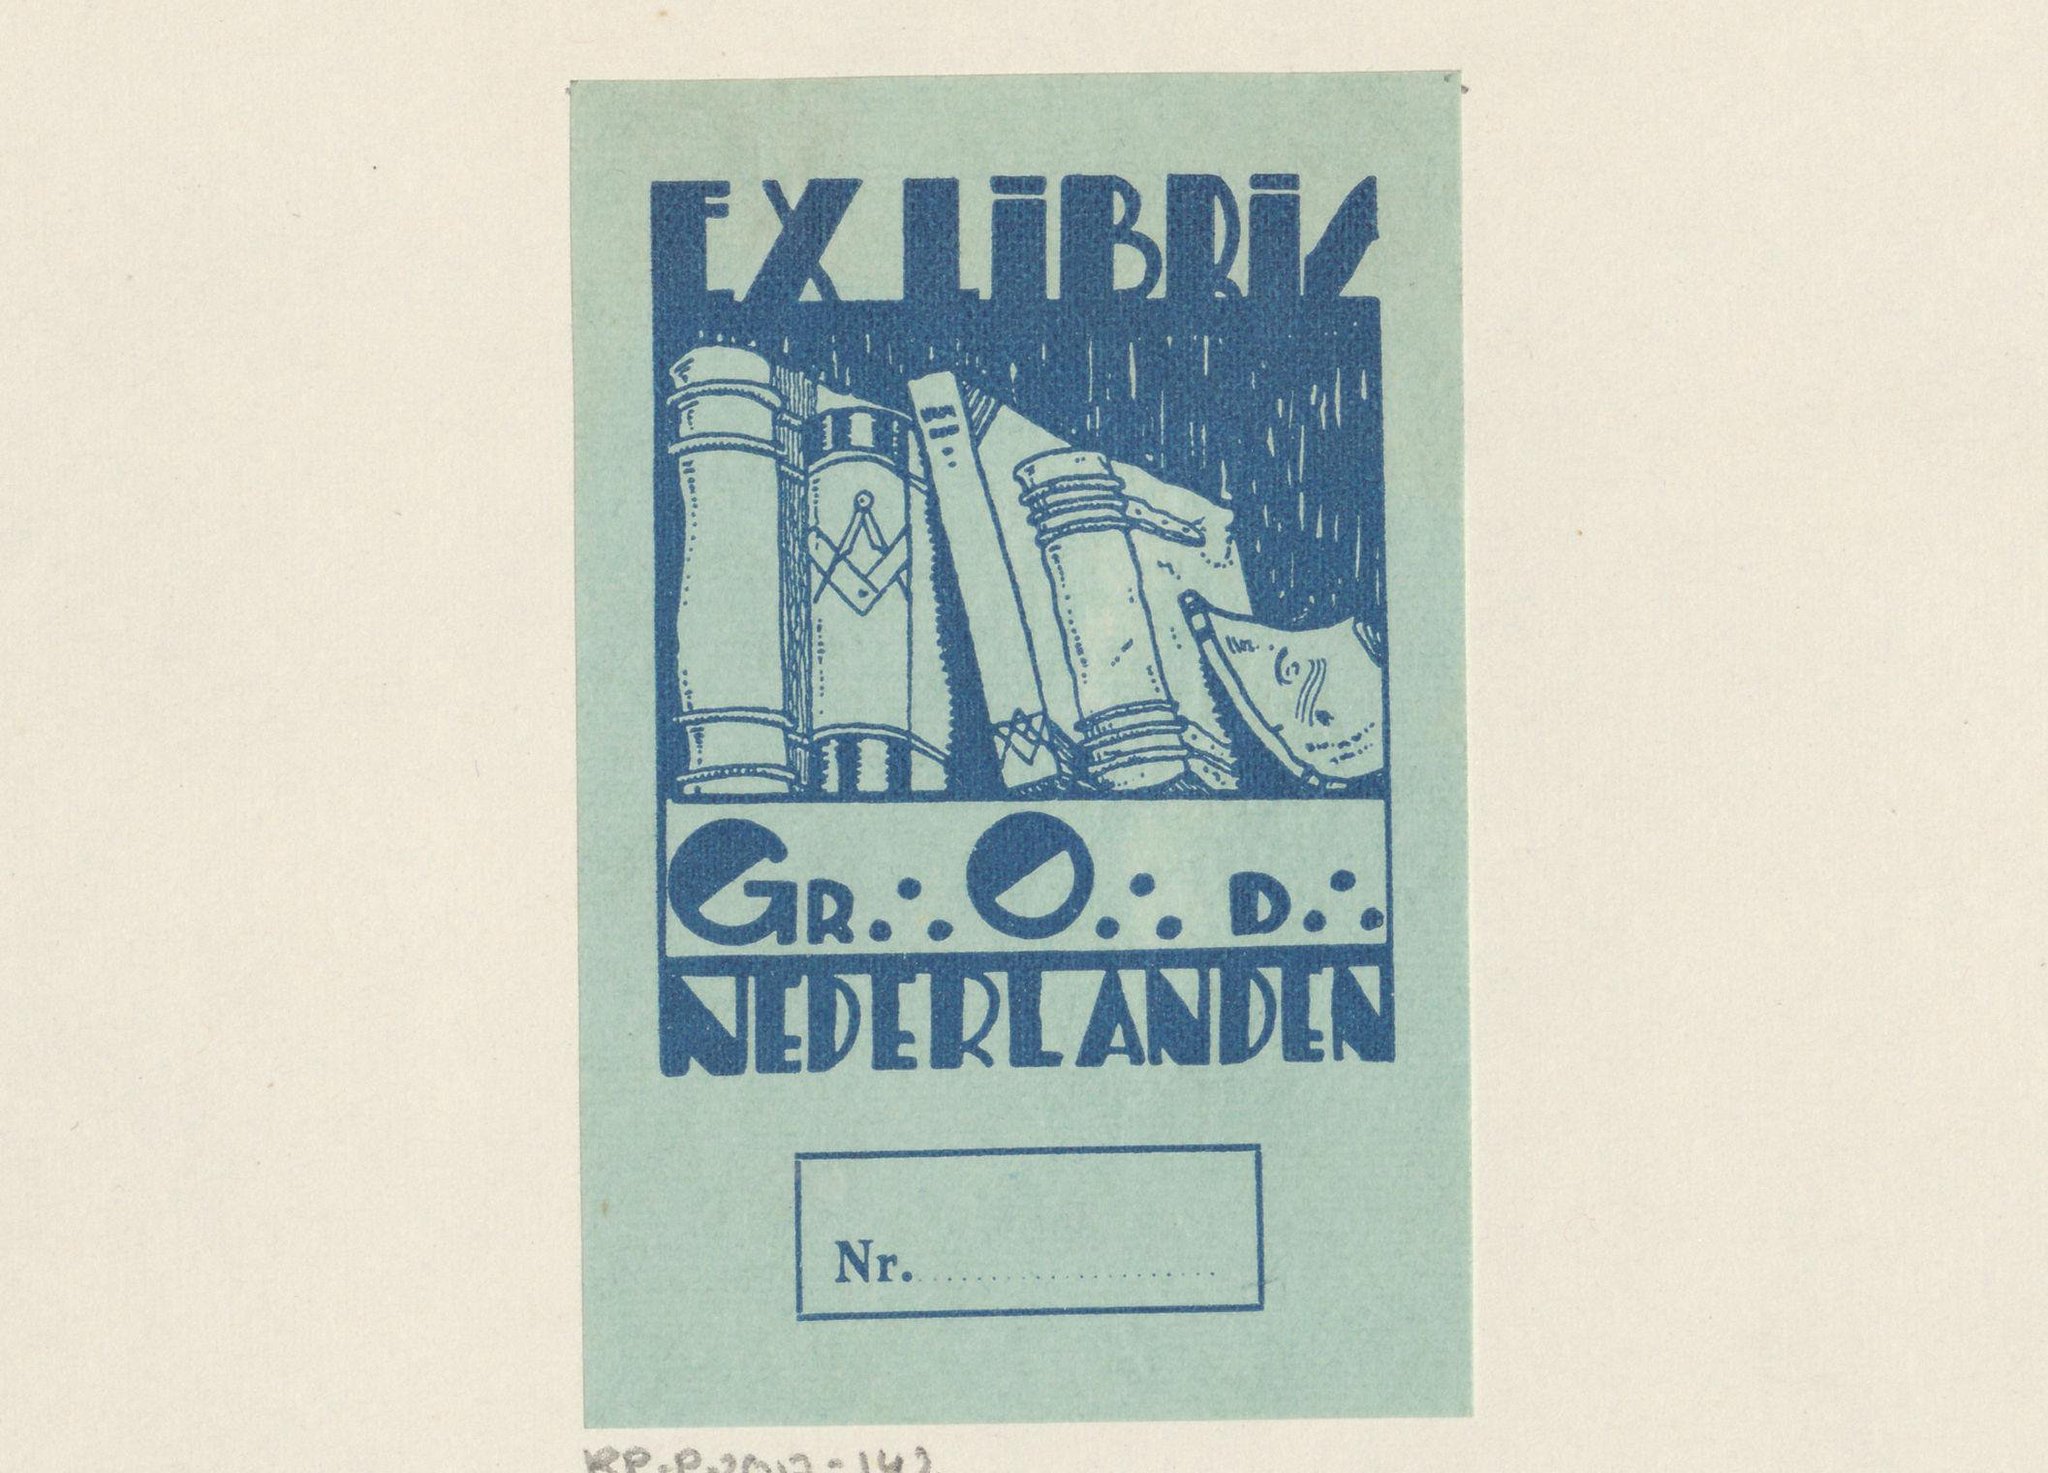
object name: bookplate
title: Ex libris van de Grootoosten der Nederlanden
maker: Anonymous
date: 1900-1999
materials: paper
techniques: printing block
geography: netherlands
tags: bookshelves, miscellaneous religions, cults and doctrines: freemasonry